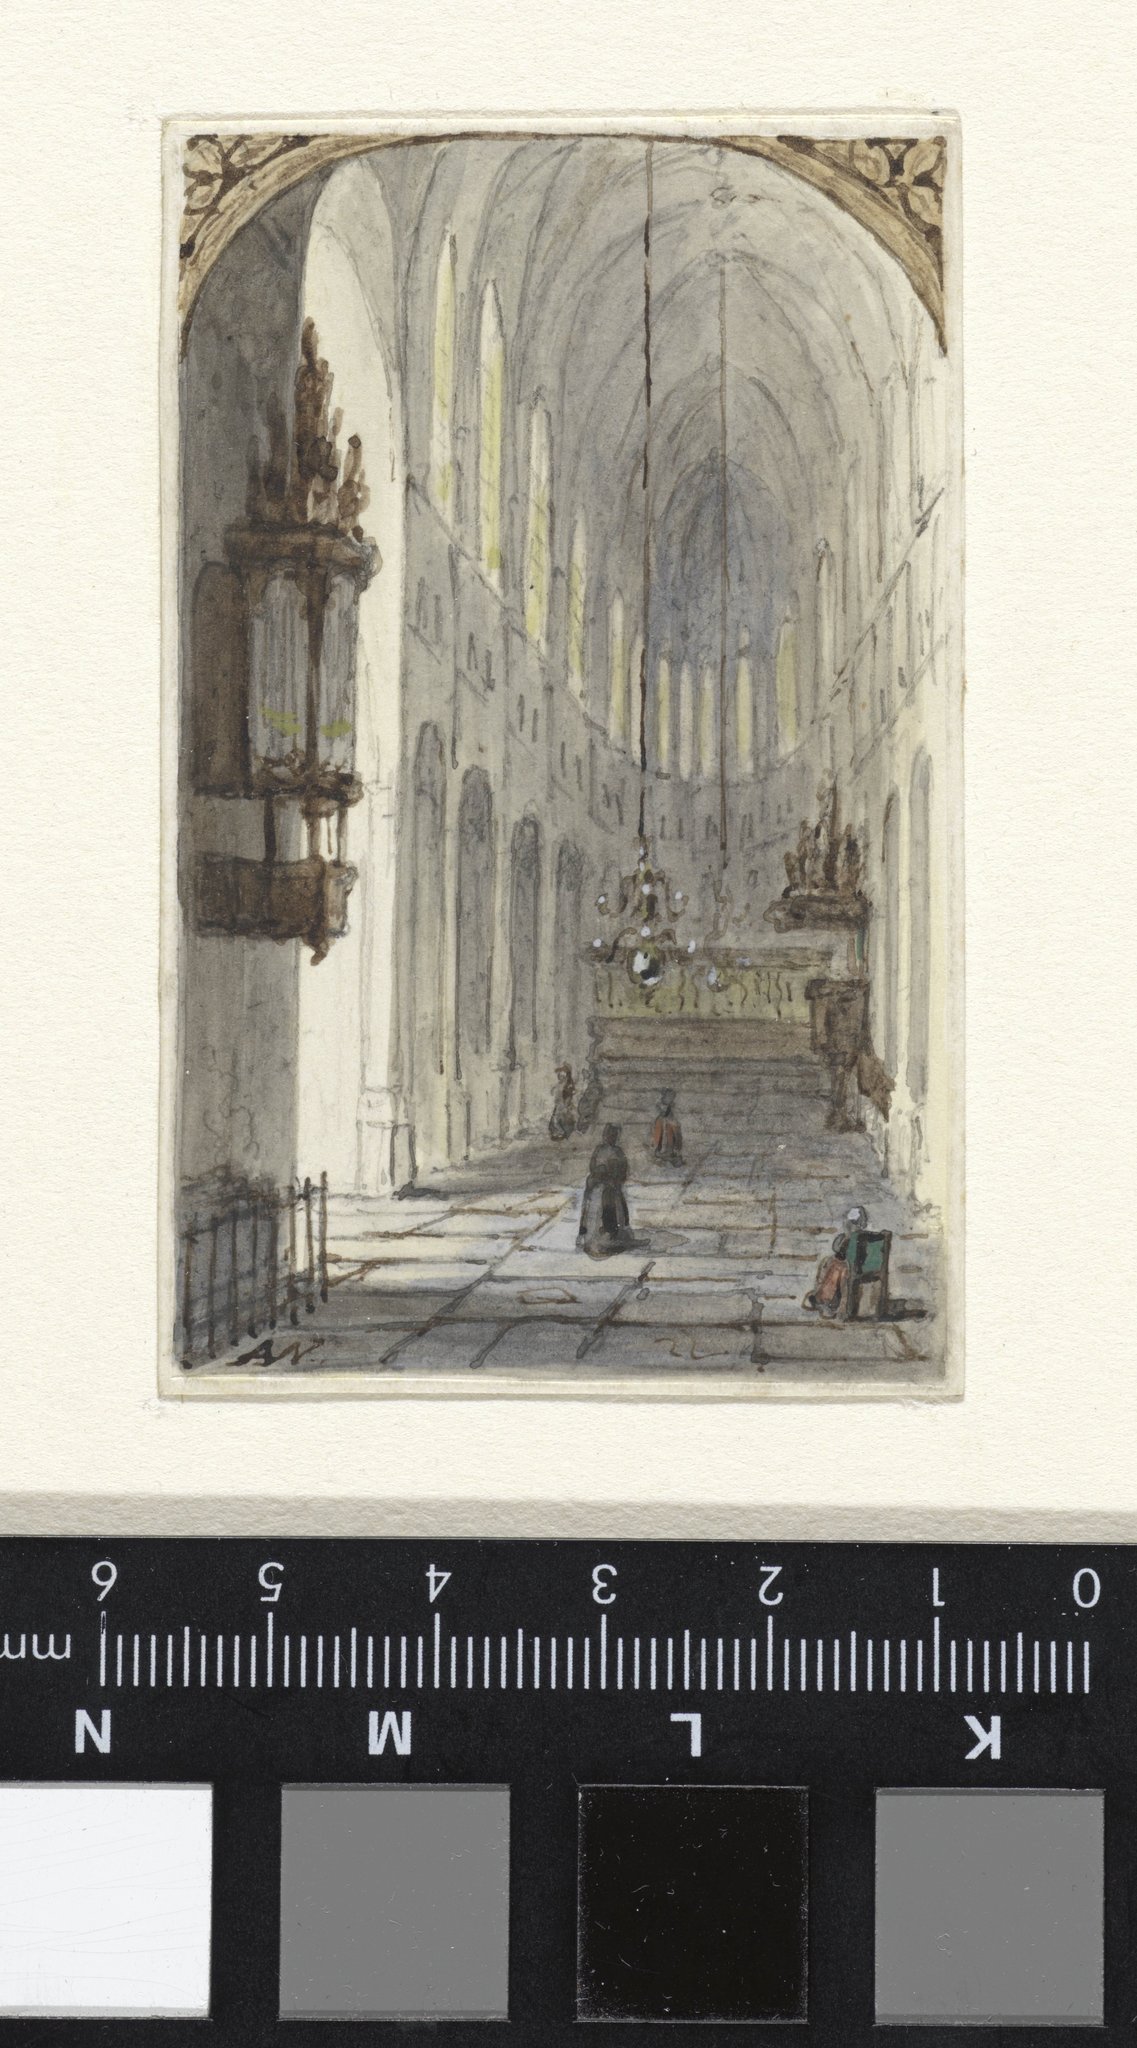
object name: drawing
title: Kerkinterieur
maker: adrianus wilhelmus nieuwenhuyzen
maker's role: draughtsman, print maker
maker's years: 1814-1894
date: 1824-1894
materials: ink, paper, pencil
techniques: brush, pen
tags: interior of church